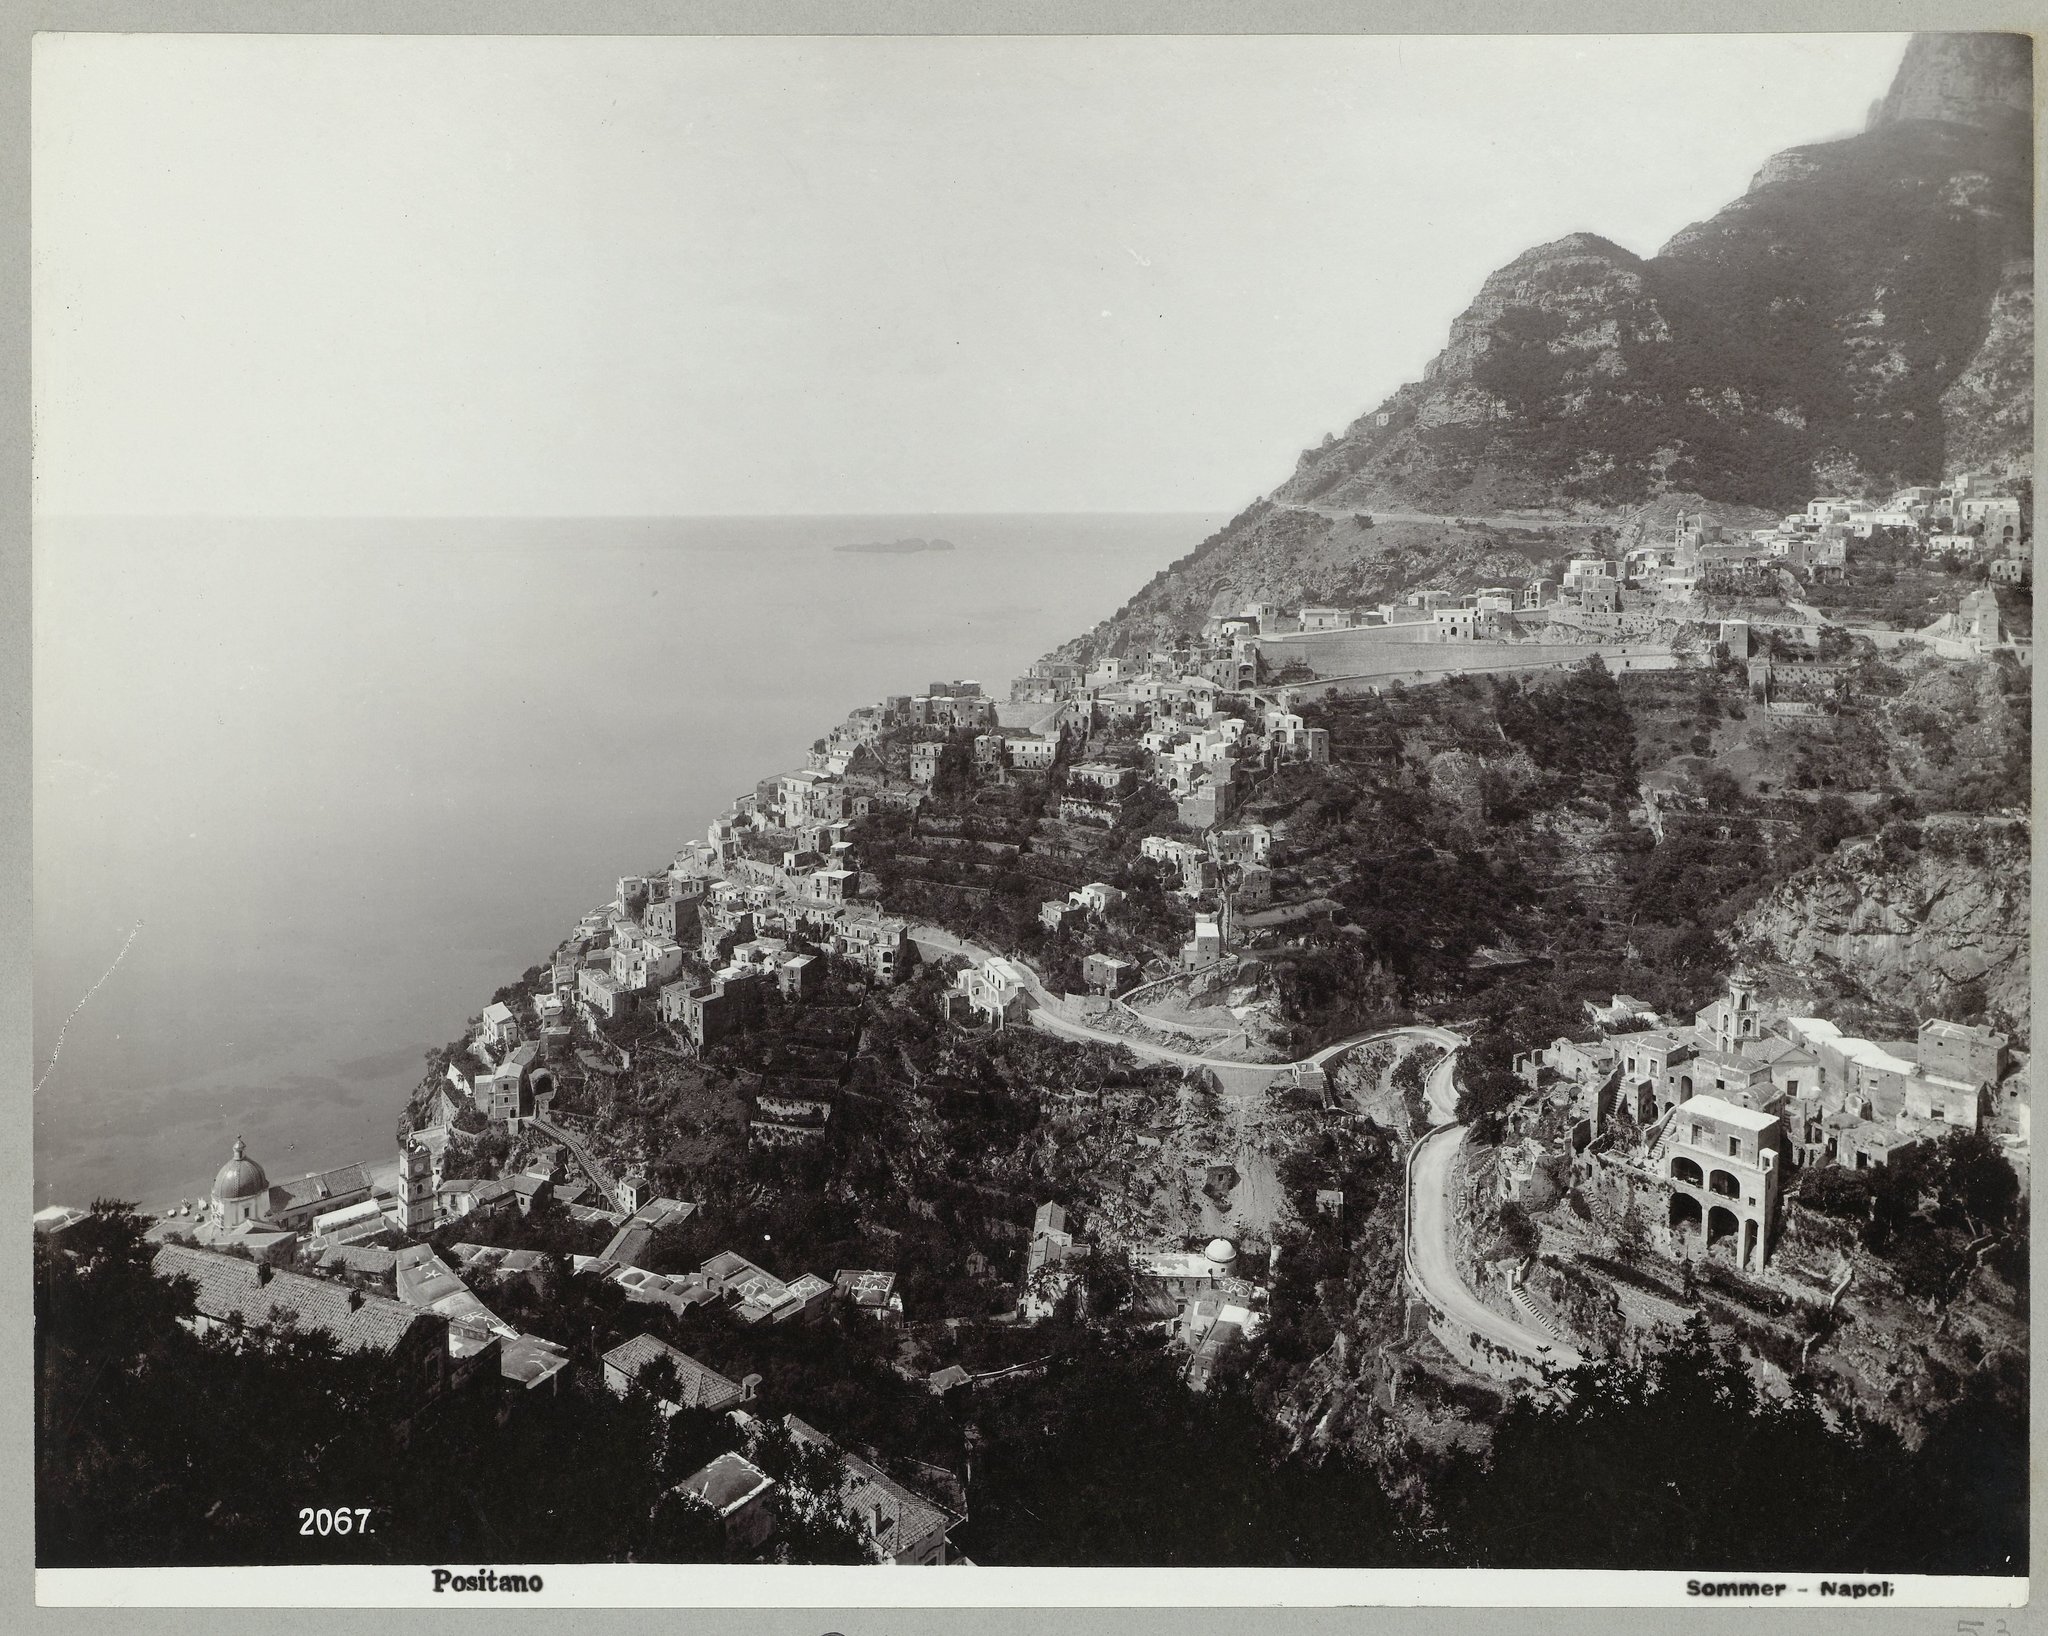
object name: photograph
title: Positano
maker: giorgio sommer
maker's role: fotograaf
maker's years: 1834-1914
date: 1888-1903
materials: cardboard, photographic support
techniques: albumen print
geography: naples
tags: positano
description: Uitzicht over de berg waarop de stad Positano is gelegen aan de kust van Amalfi.